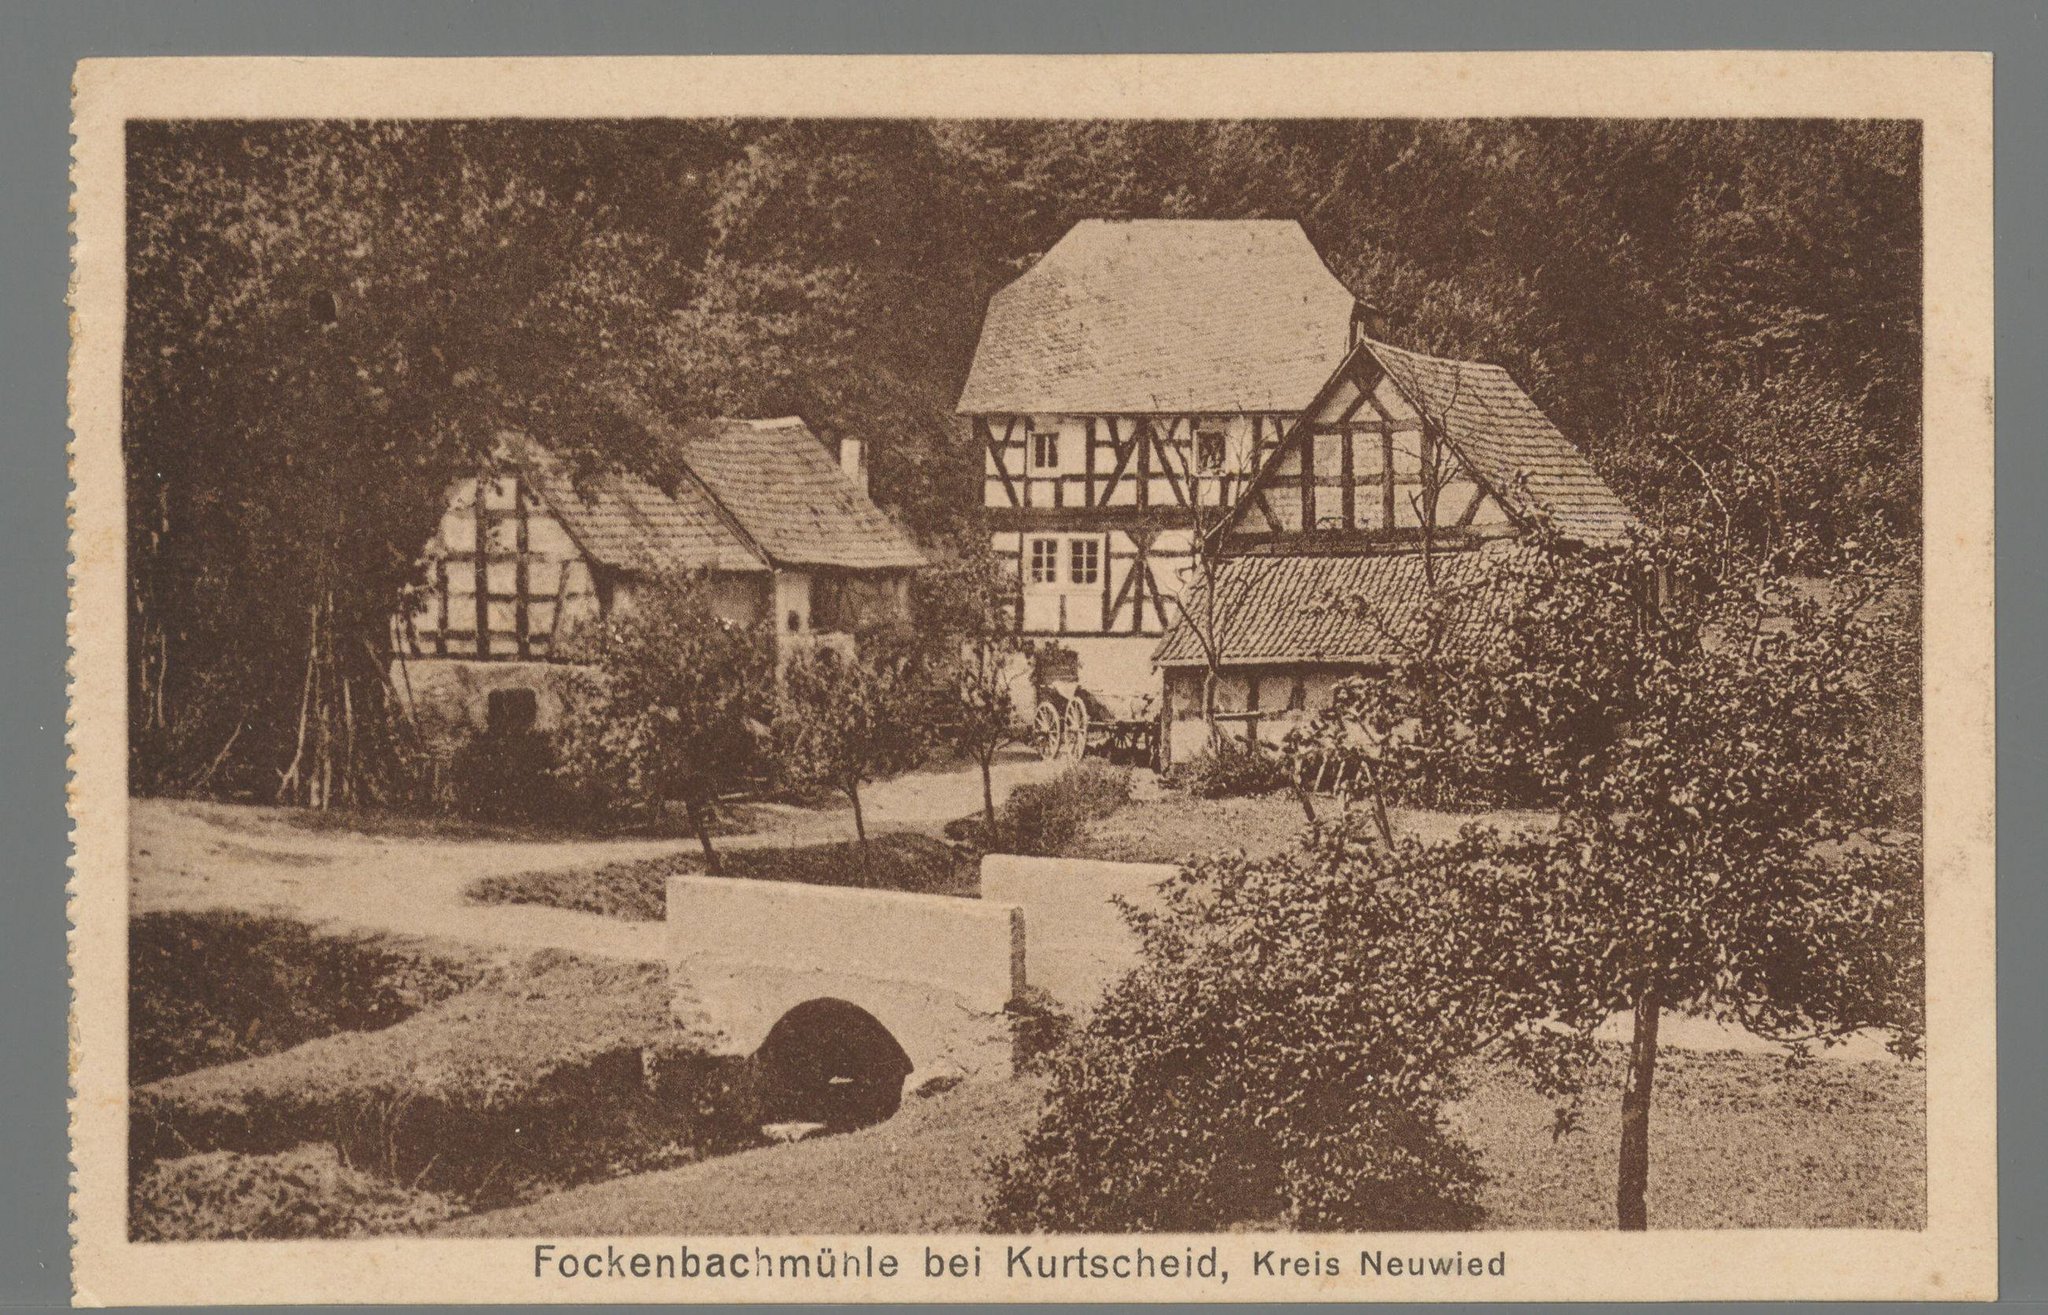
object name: ansichtkaart, prentbriefkaart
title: Fockenbachmühle bei Kurtscheid, Kreis Neuwied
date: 1905-1930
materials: cardboard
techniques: photograph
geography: kurtscheid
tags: windmill